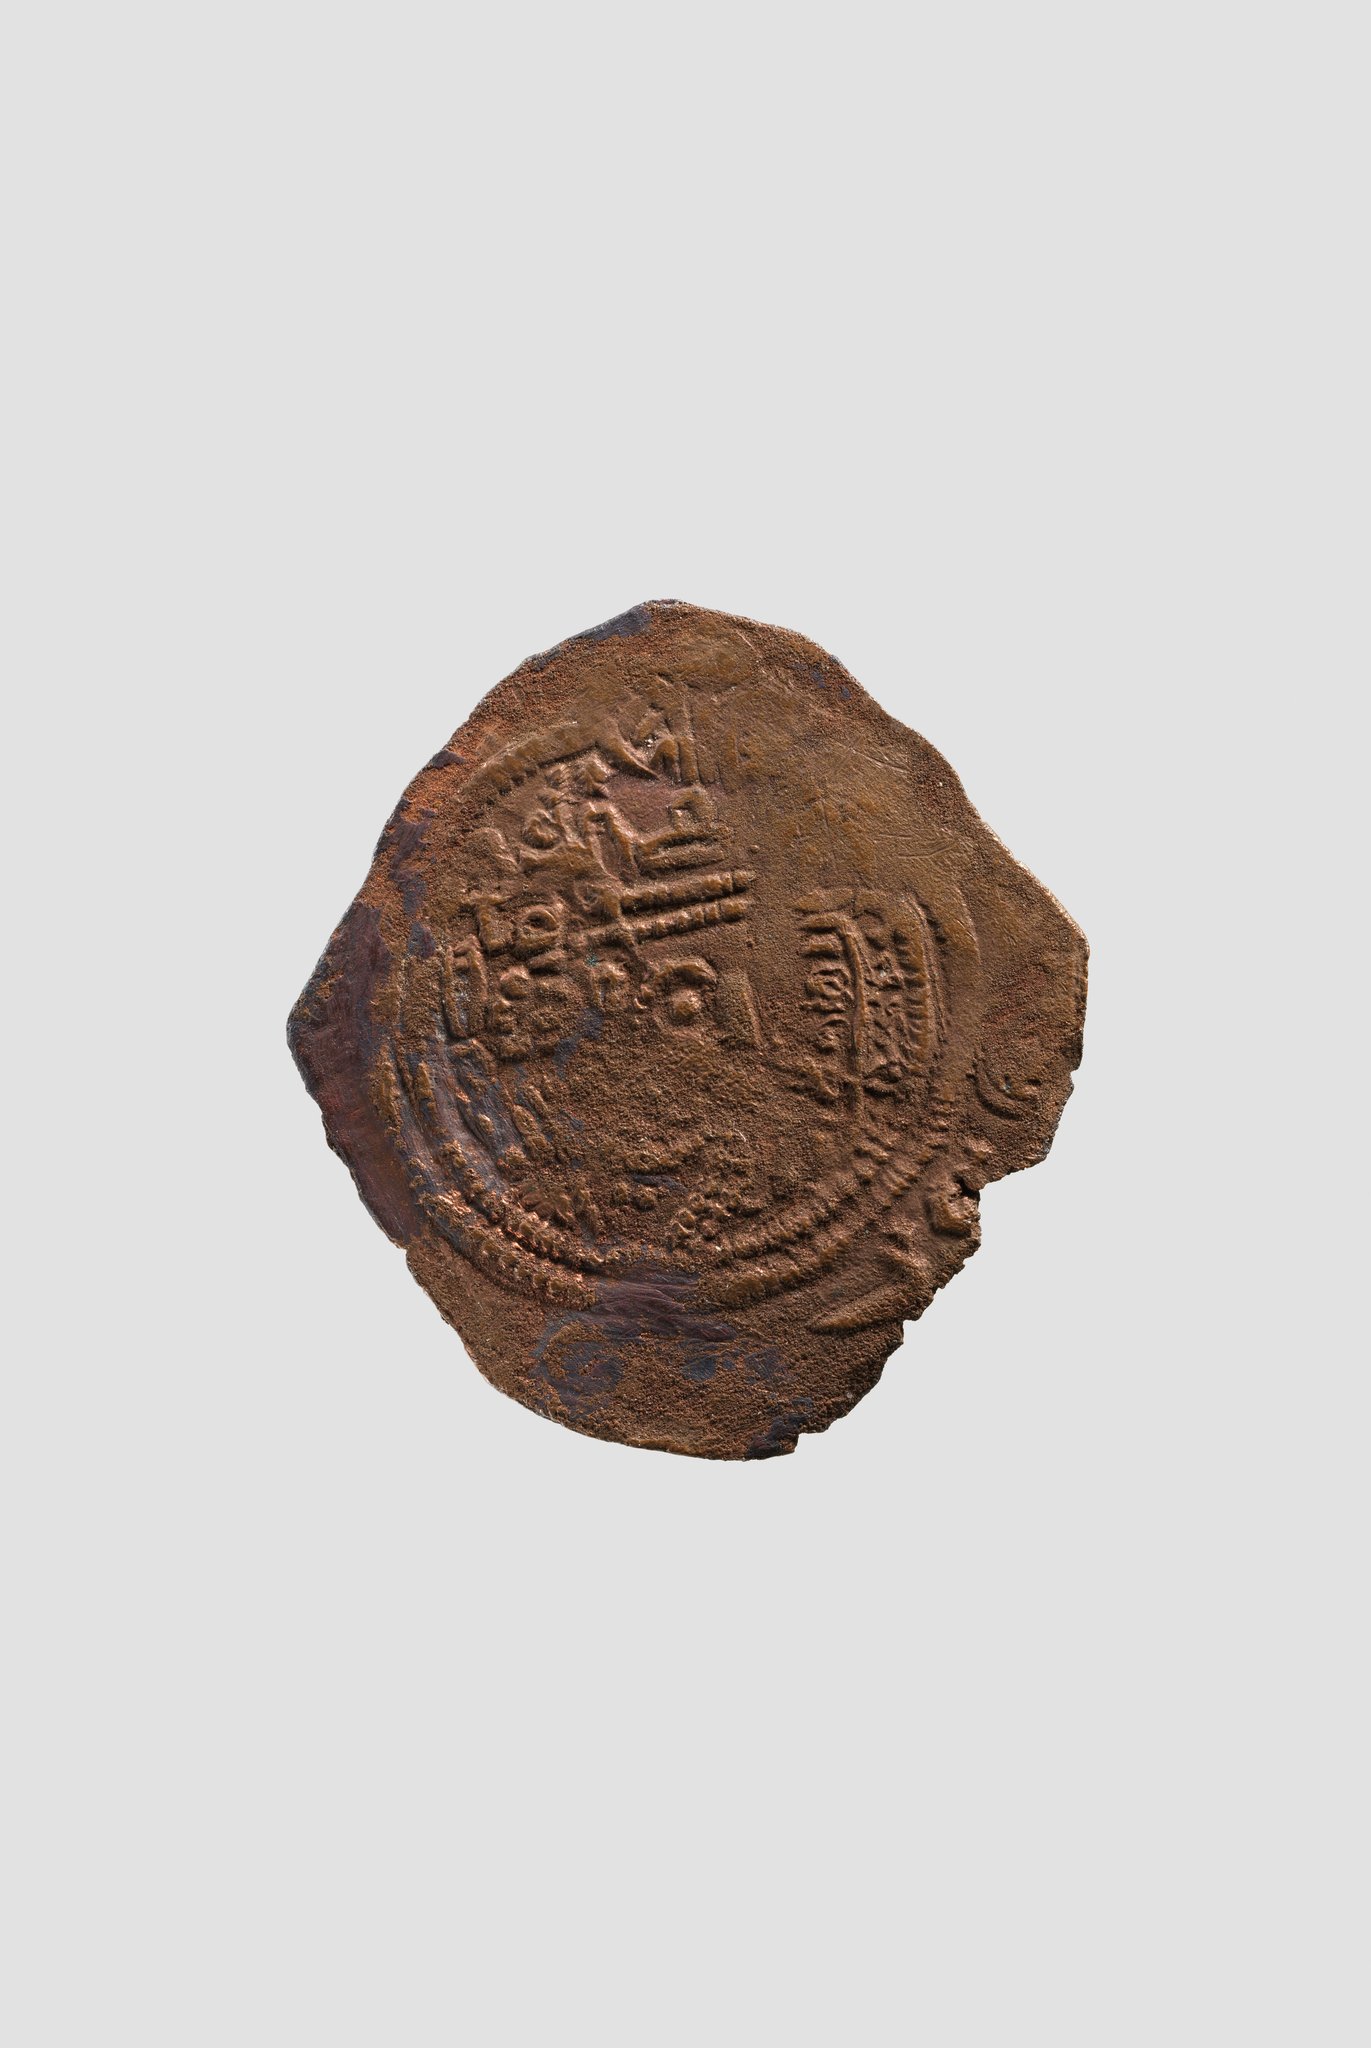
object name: coin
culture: islamic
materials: copper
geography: iran